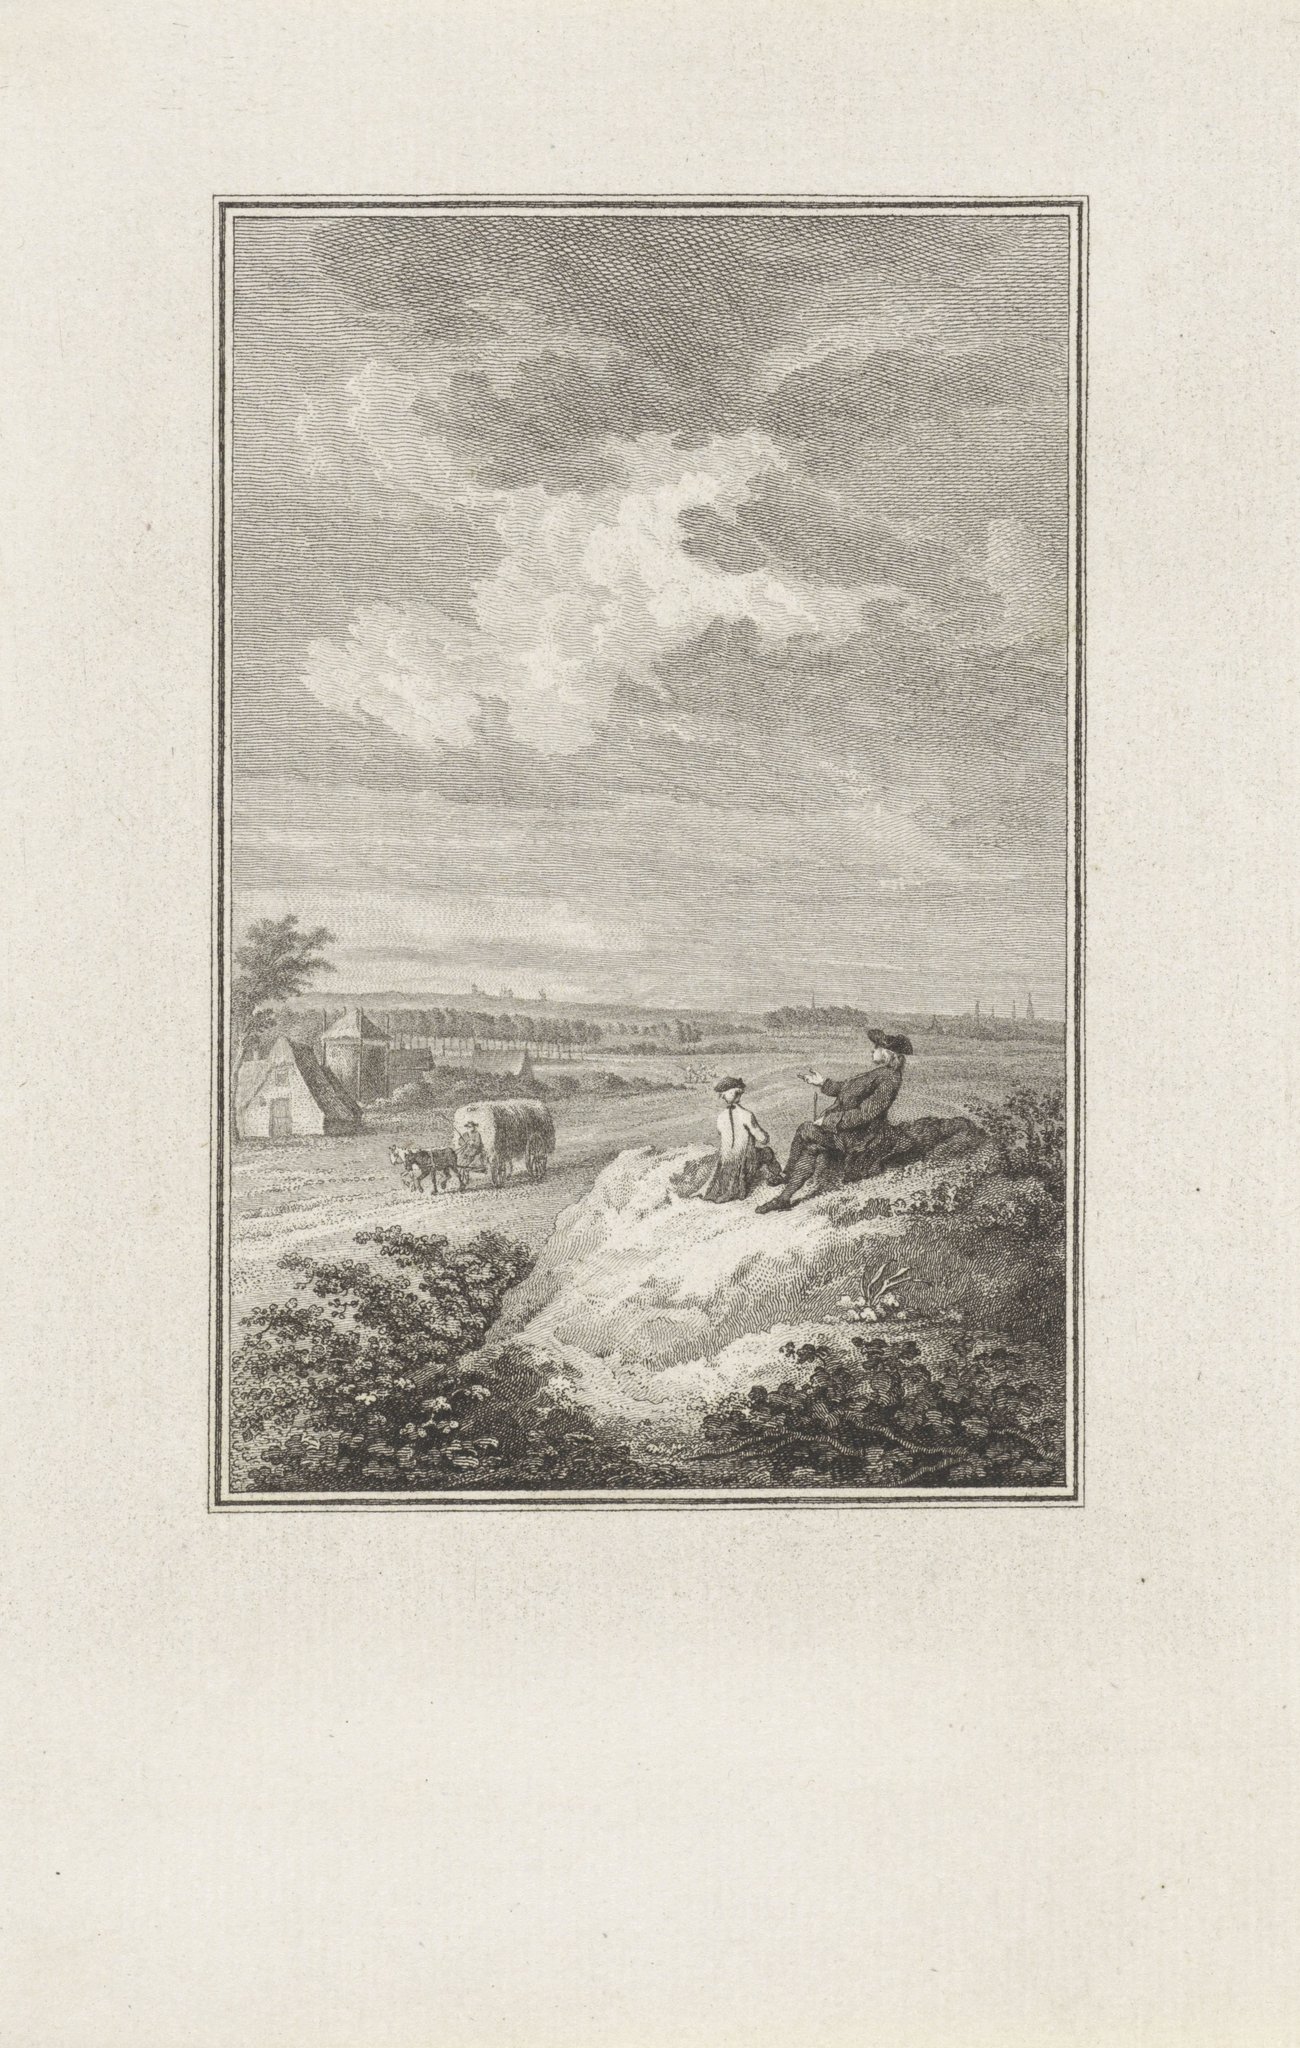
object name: print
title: Gezicht vanaf een heuvel op Zutphen, Halle, Eerbeek, Voorst en Deventer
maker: reinier vinkeles (i)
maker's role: draughtsman, print maker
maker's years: 1741-1816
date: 1786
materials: paper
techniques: engraving, etching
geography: amsterdam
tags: conversation, dialogue; conversation piece, hay-wagon, (high) hill (+ landscape with figures, staffage), deventer, halle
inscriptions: collector's mark: Lugt 240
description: Latere staat prent gebruikt als illustratie in: Martinet, Joannes Florentius. Katechismus der natuur. Amsterdam: Johannes Allart, 1786.